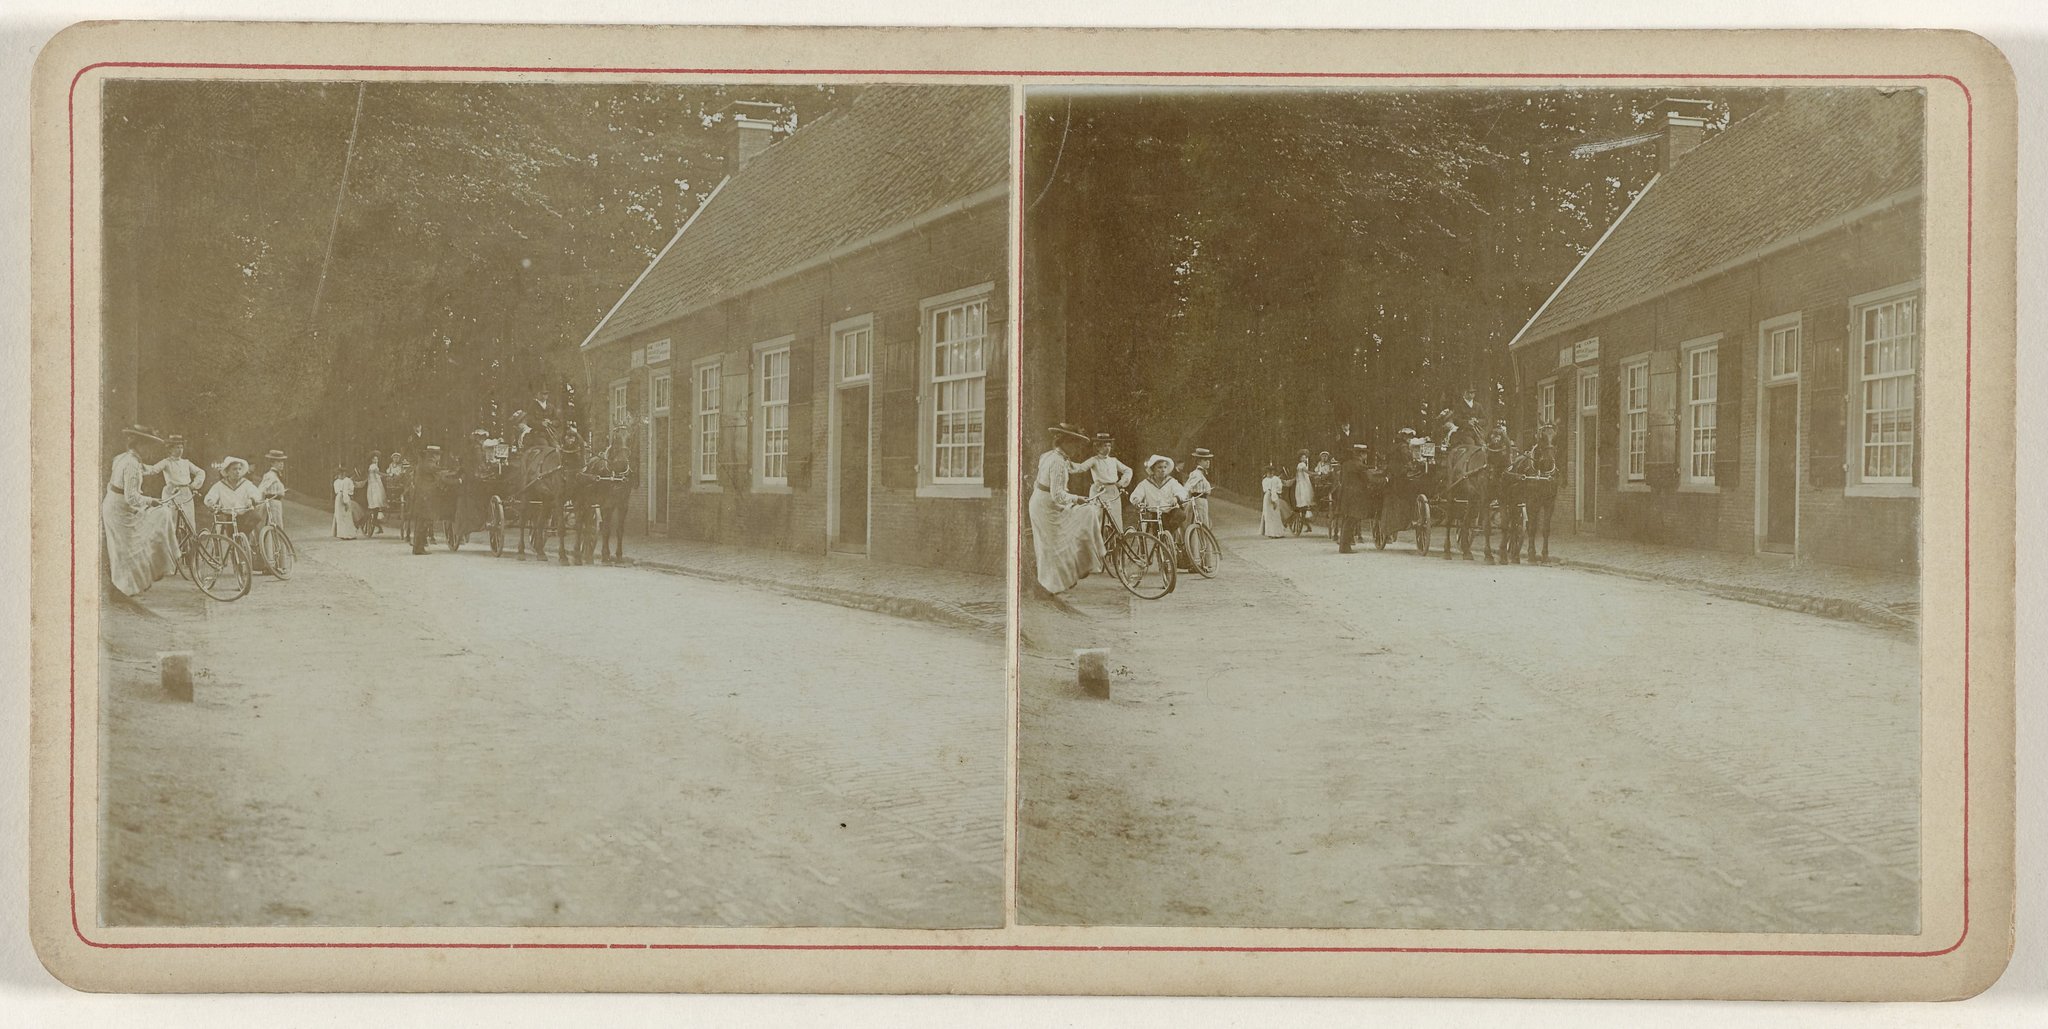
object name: stereograph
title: Diepe put bij Hoog Soeren 1904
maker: geldolph adriaan kessler (dolph)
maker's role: fotograaf, industrieel, voetballer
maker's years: 1884-1945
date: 1904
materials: paper, photographic support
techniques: collodion silver print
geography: netherlands